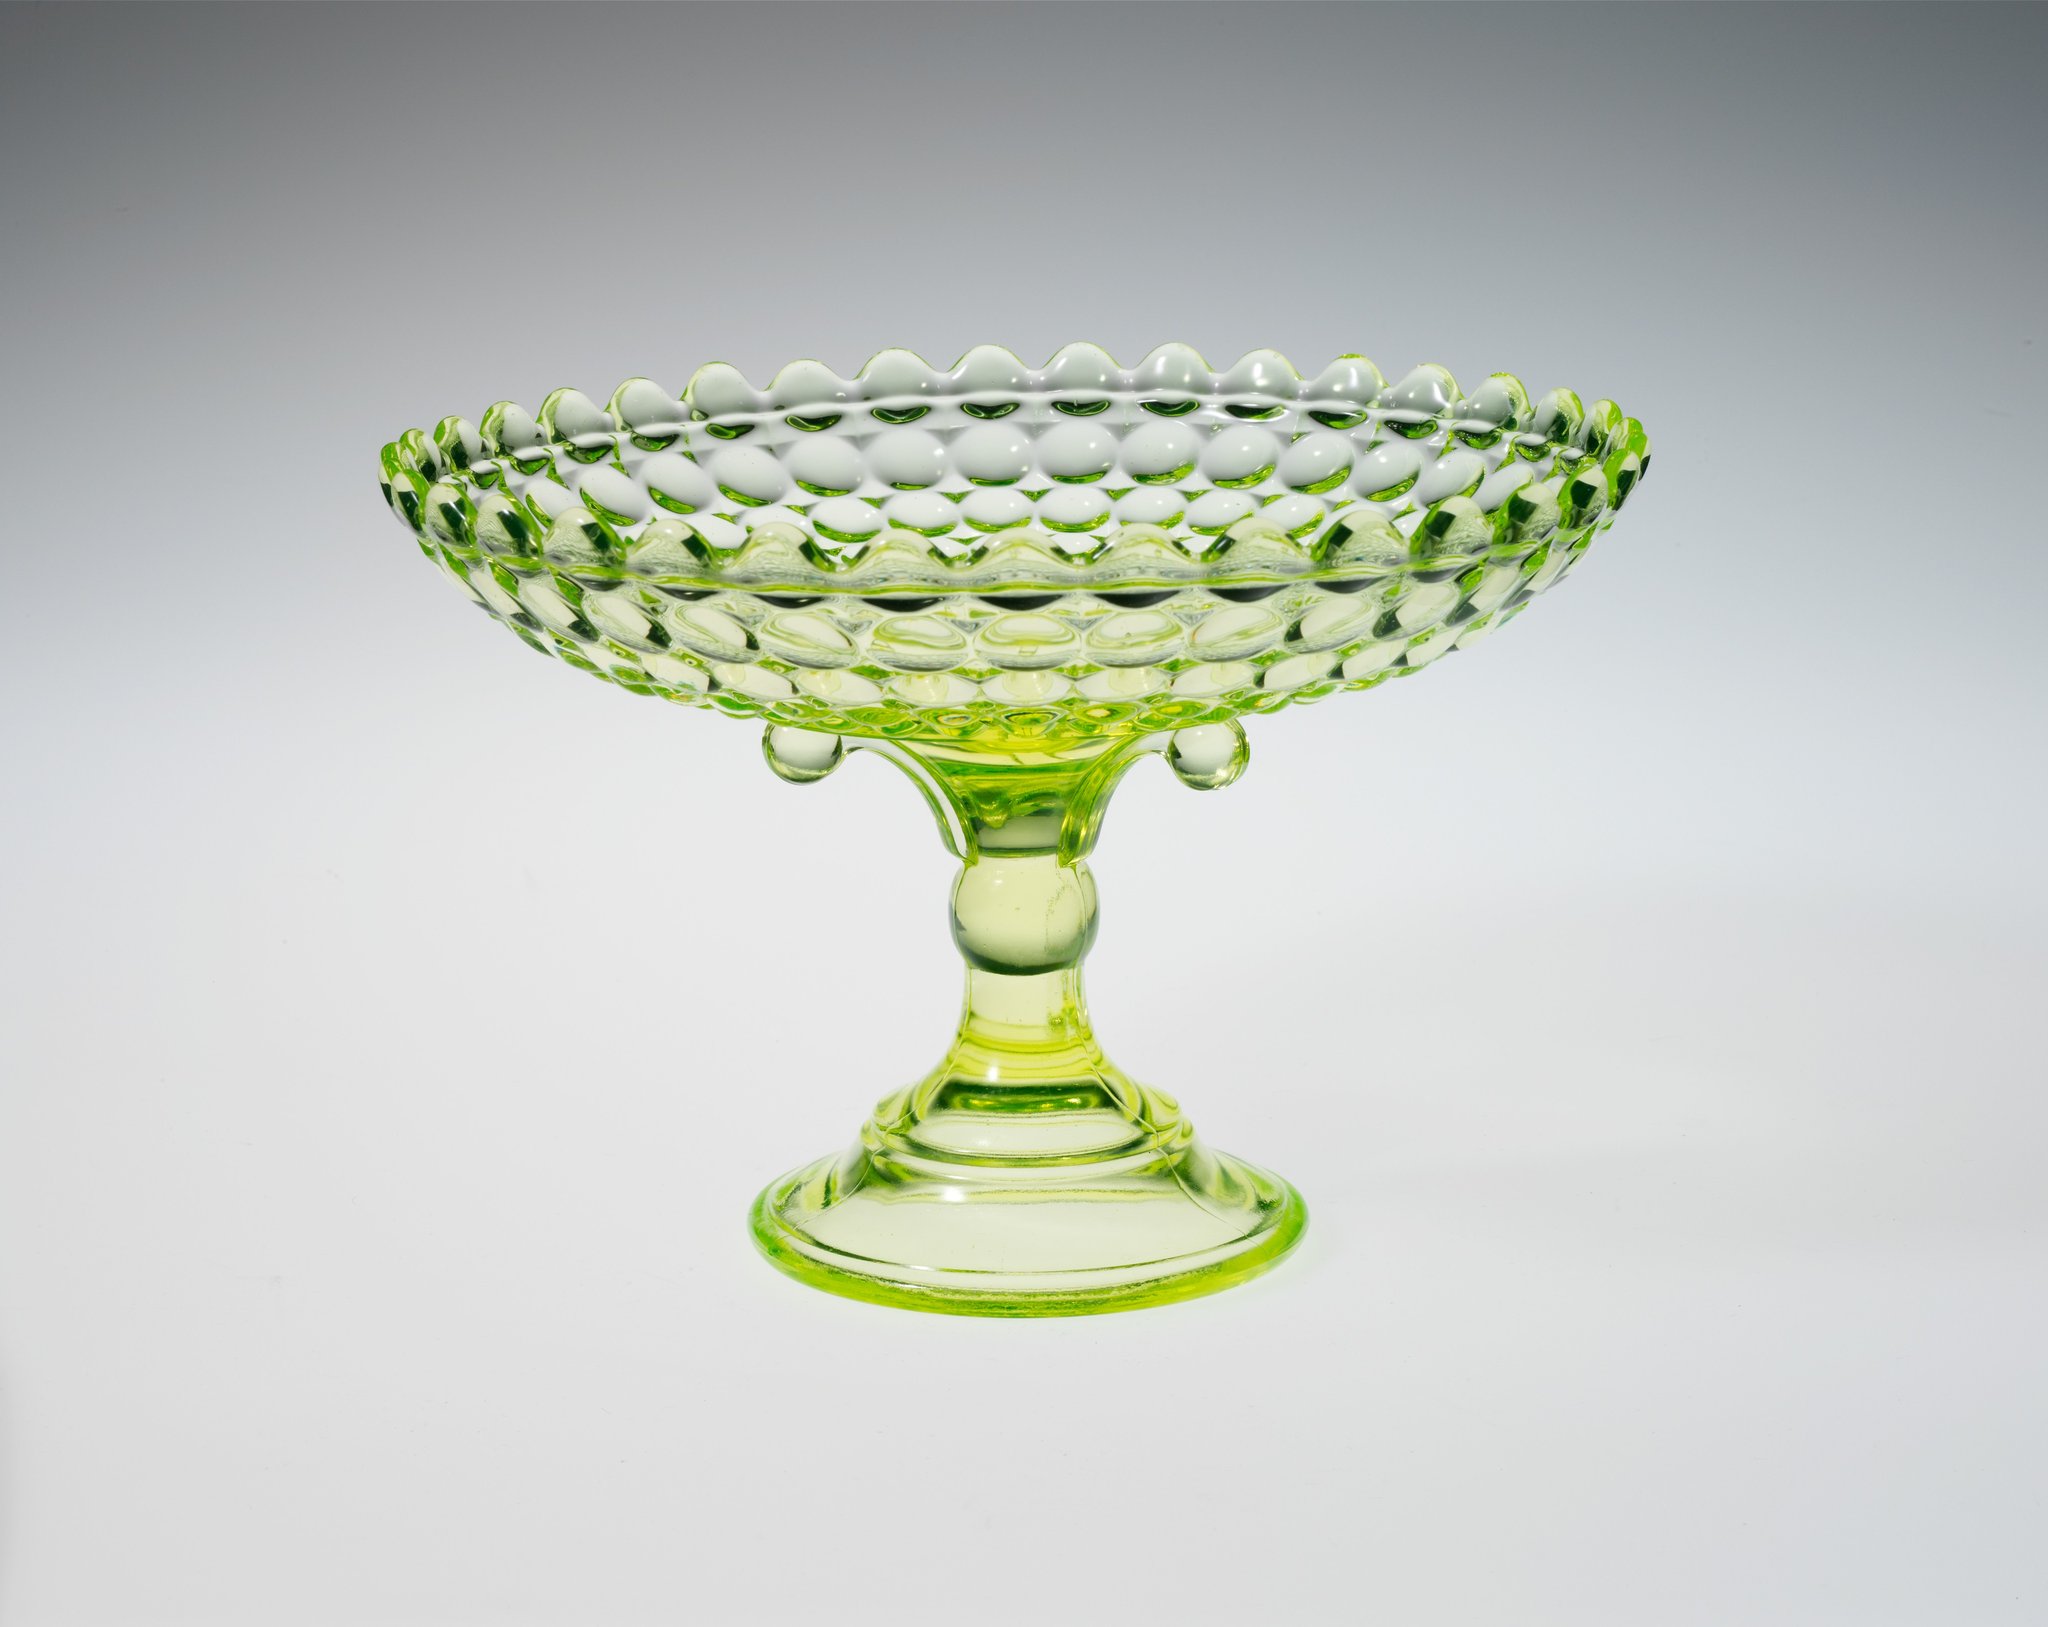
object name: compote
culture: american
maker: adams and company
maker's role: maker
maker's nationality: american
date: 1870-1890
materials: glass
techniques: pressed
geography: united states